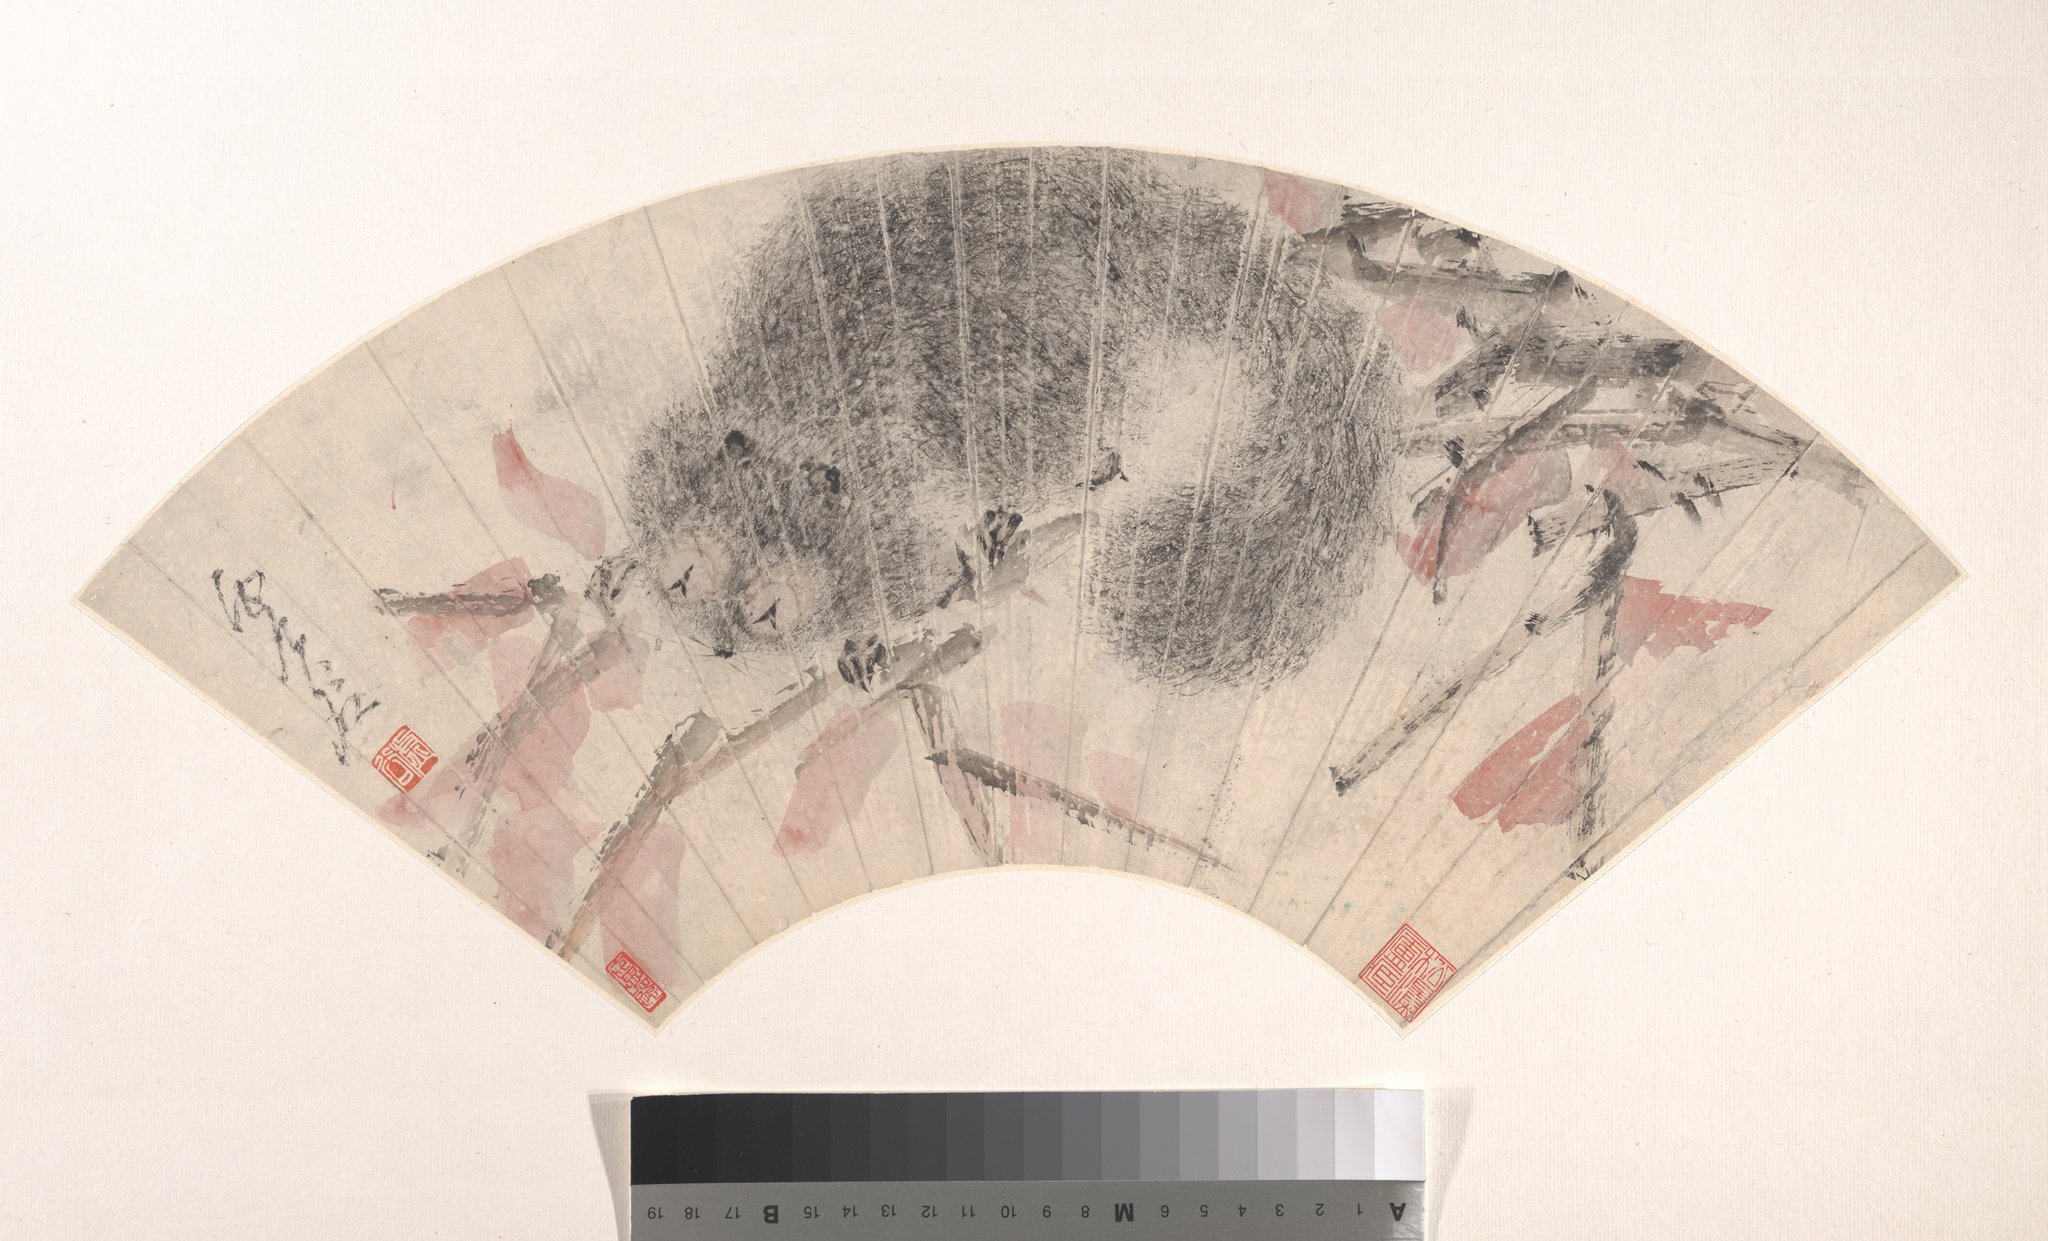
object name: folding fan mounted a an album leaf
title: Squirrel on an Autumn Branch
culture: chinese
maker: xugu (zhu huairen)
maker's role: artist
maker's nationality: chinese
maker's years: 1823-1896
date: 1880-1889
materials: ink, paper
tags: squirrels